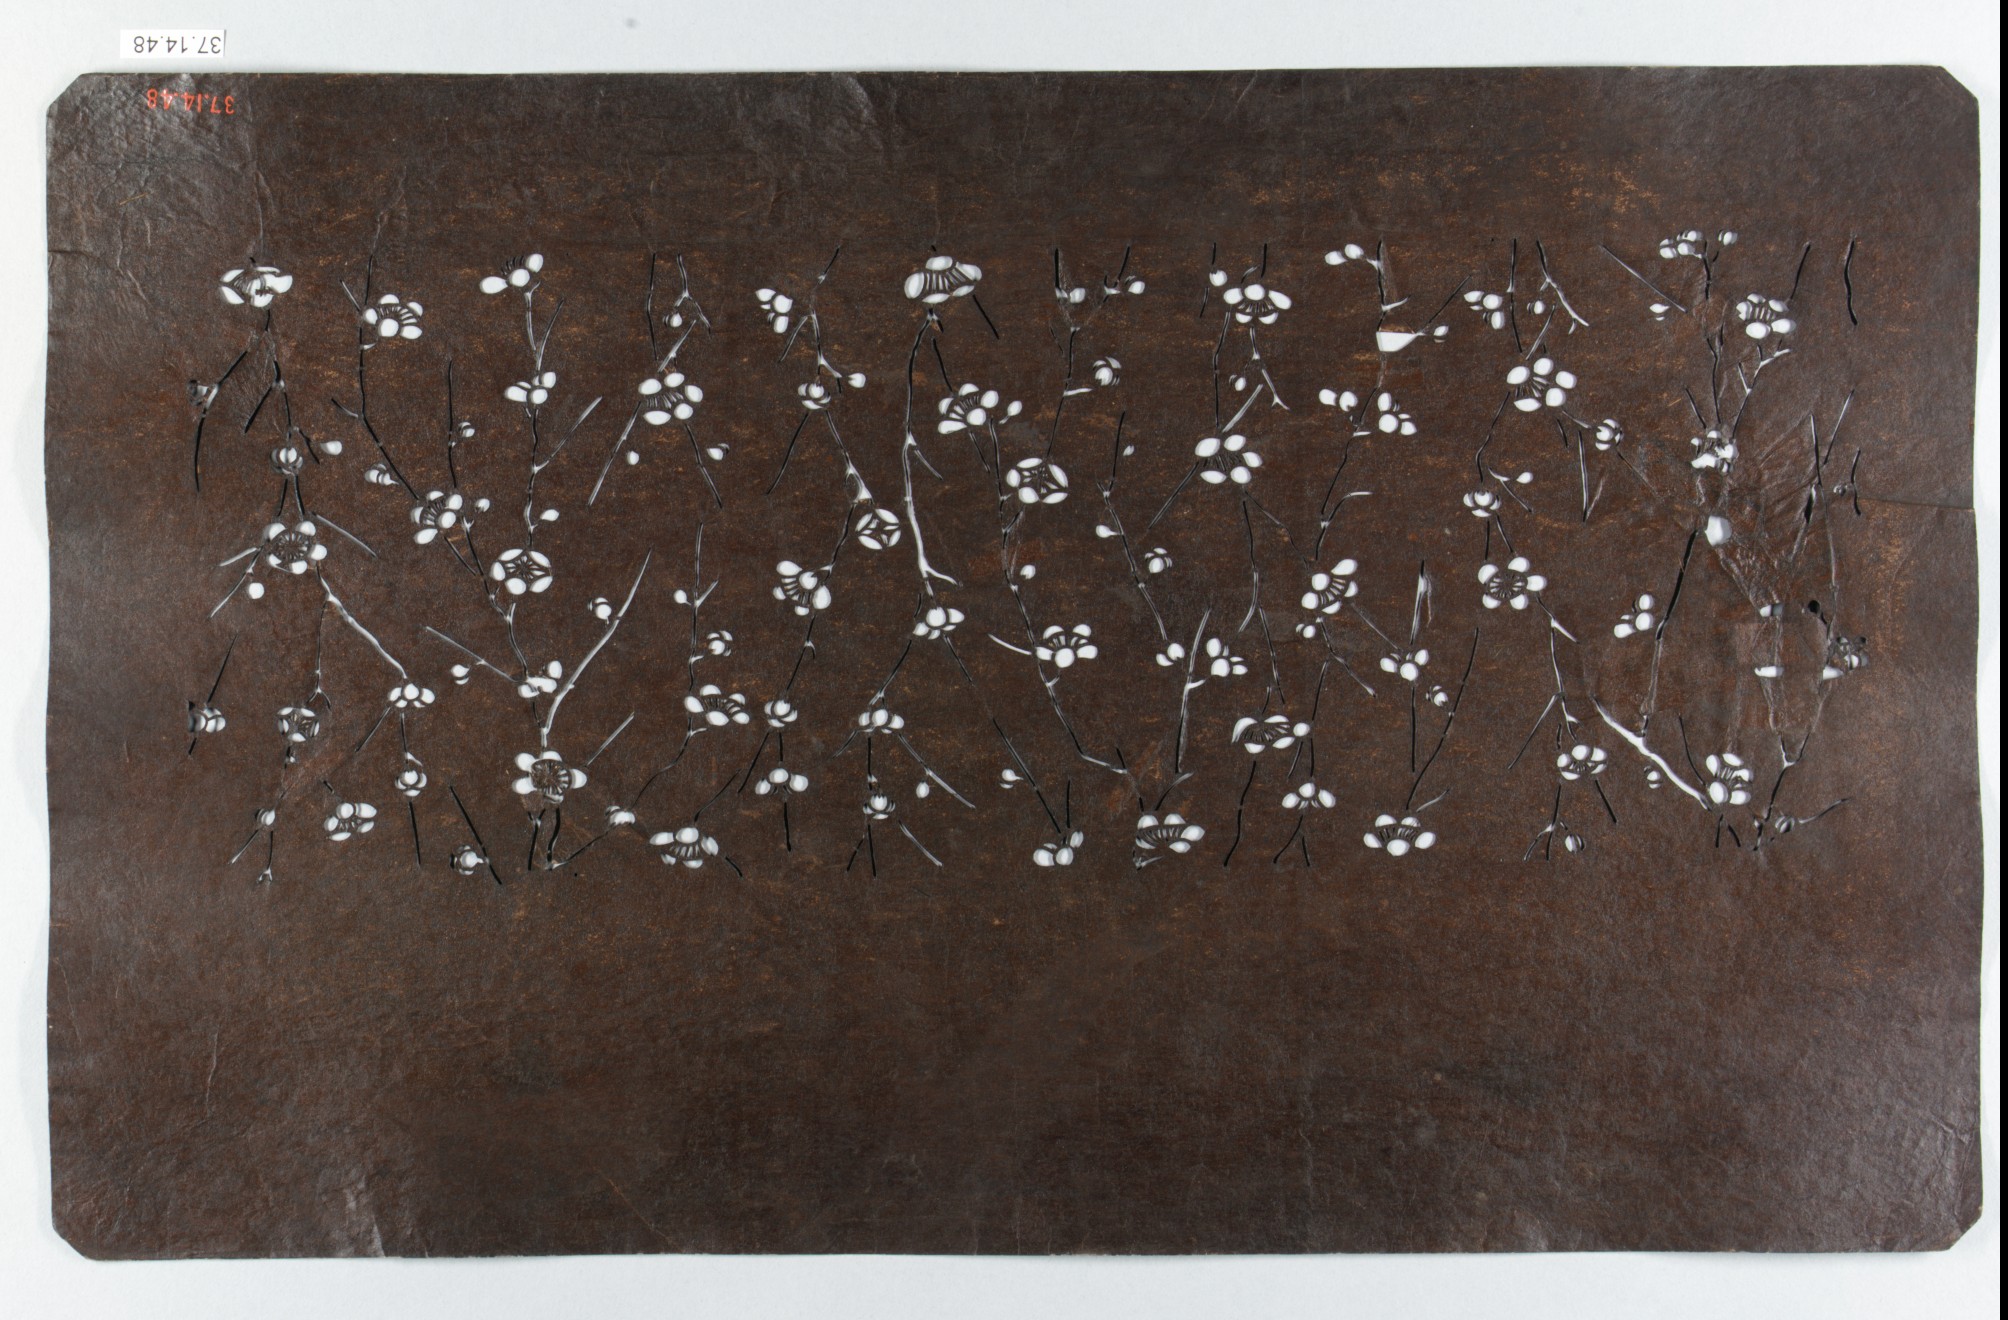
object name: stencil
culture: japanese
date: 1801-1833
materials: paper